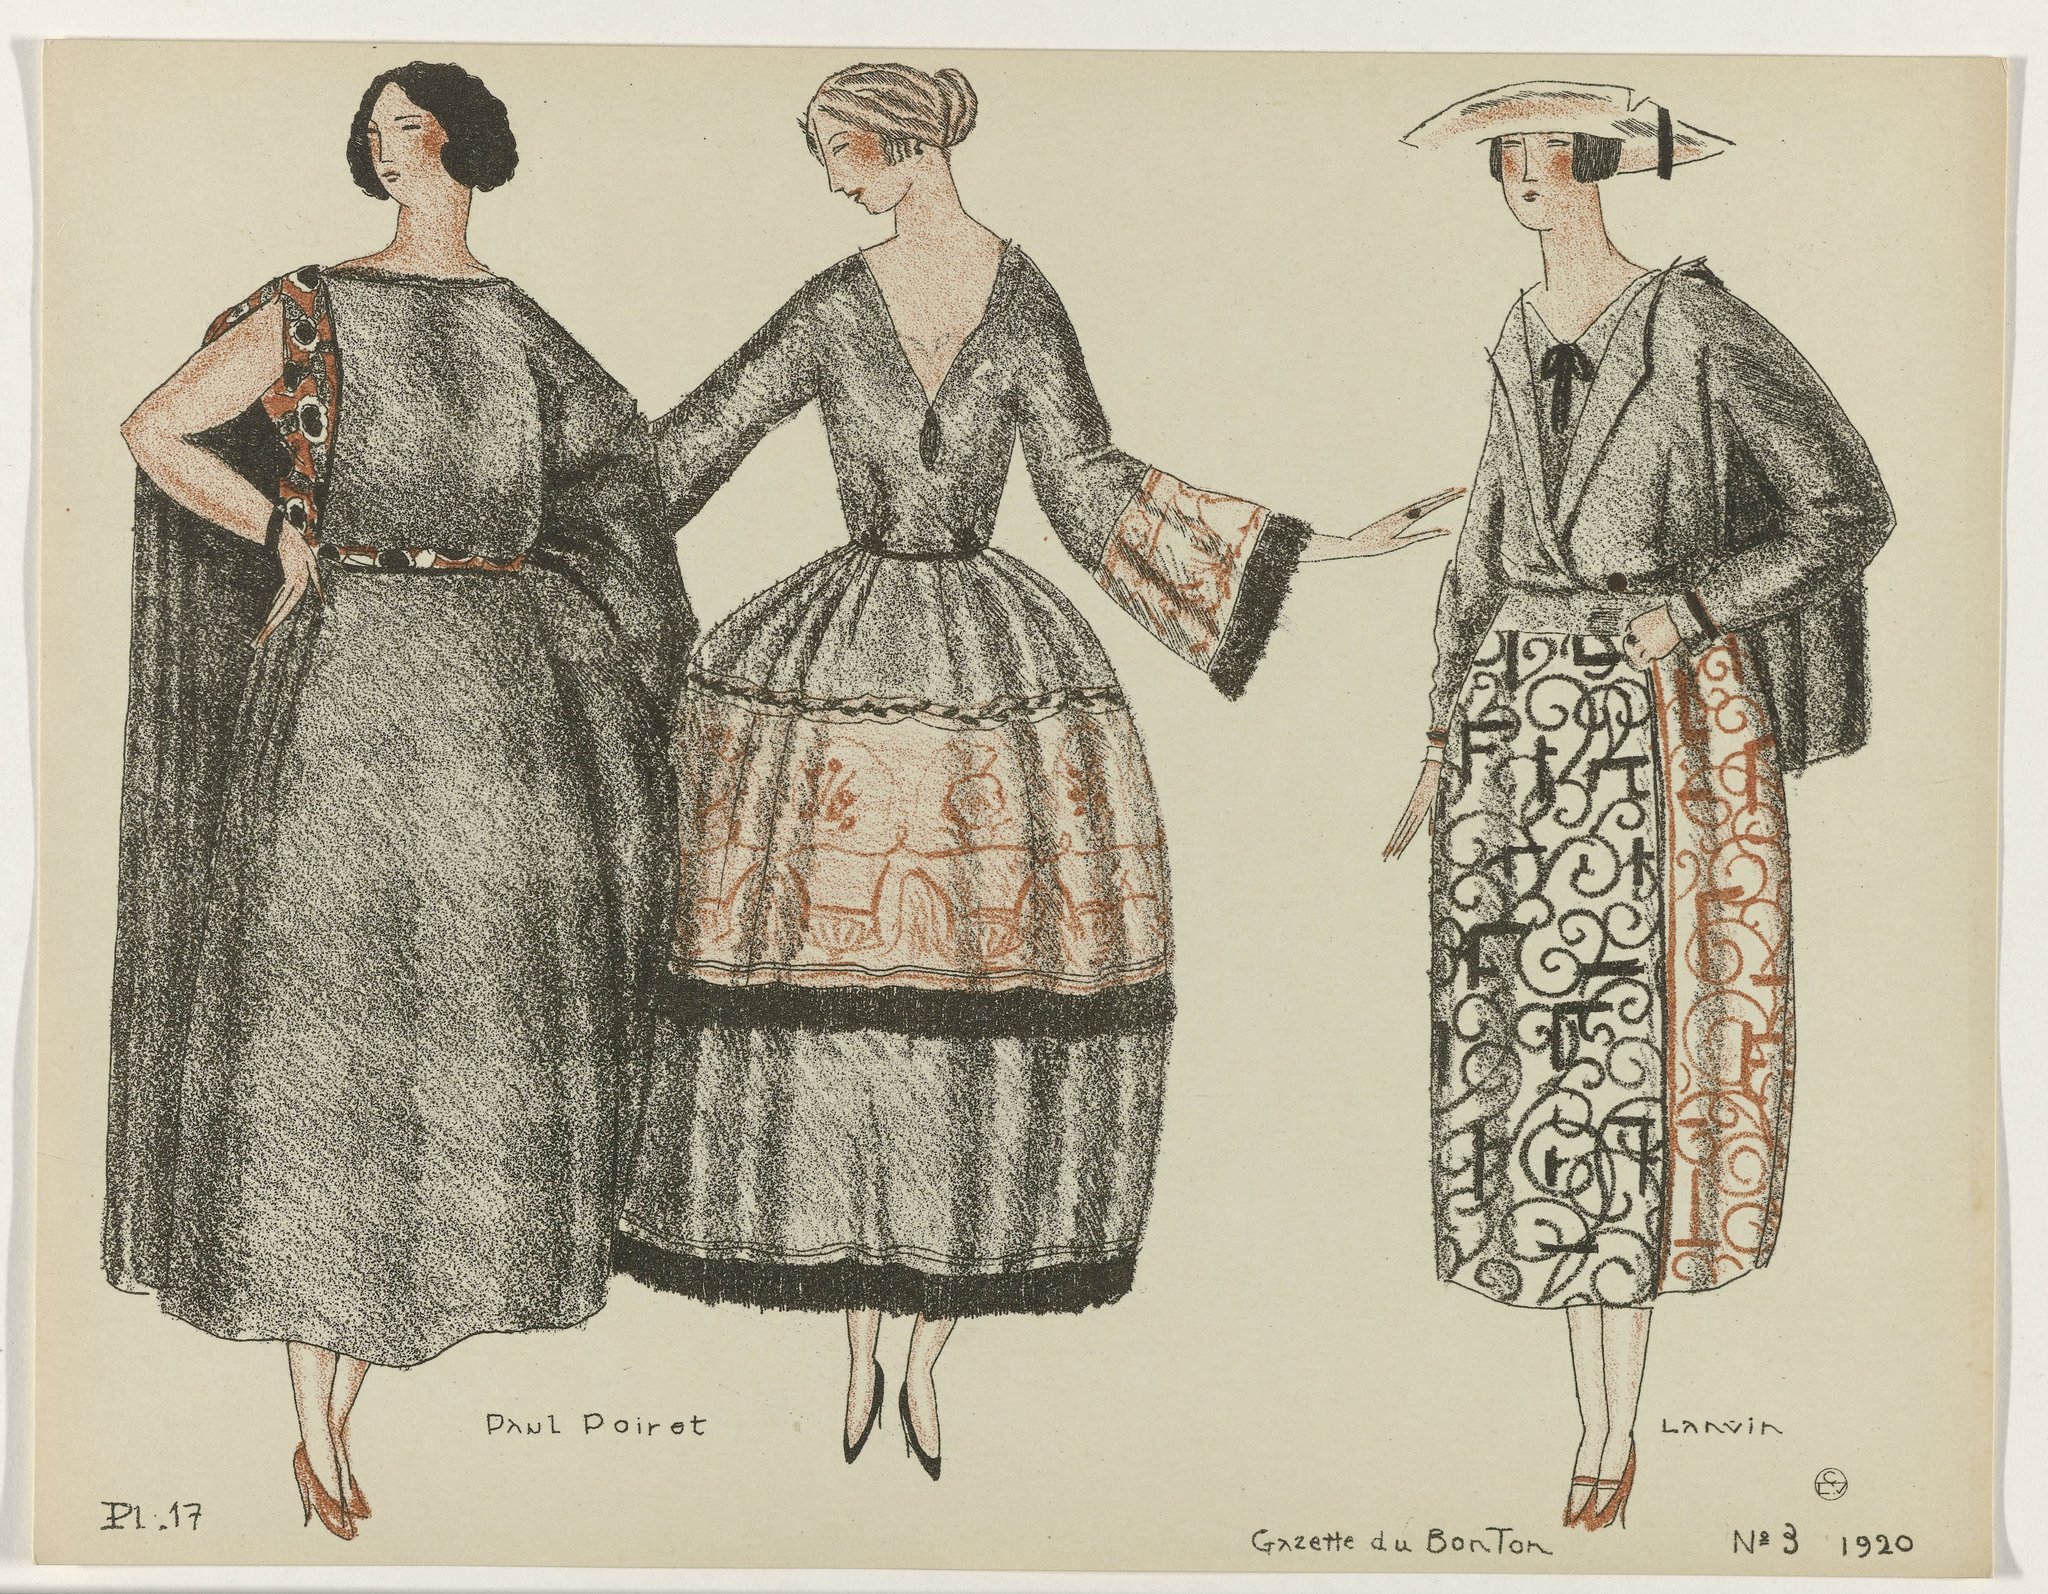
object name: fashion print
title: Gazette du Bon Ton, 1920 - No. 3, Croquis Pl. 17: Paul Poiret / Lanvin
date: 1920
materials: paper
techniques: lithograph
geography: paris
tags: coat (+ women's clothes), head-gear (+ women's clothes), fashion plates, dress, gown (+ women's clothes)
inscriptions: date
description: Twee japonnen met borduursels van Paul Poiret en een geborduurde japon met een kleine mantel van Lanvin. Croquis Pl. 17 uit Gazette du Bon Ton 1920, No. 3. Uitleg over de kleding op pagina "Explication des Planches".